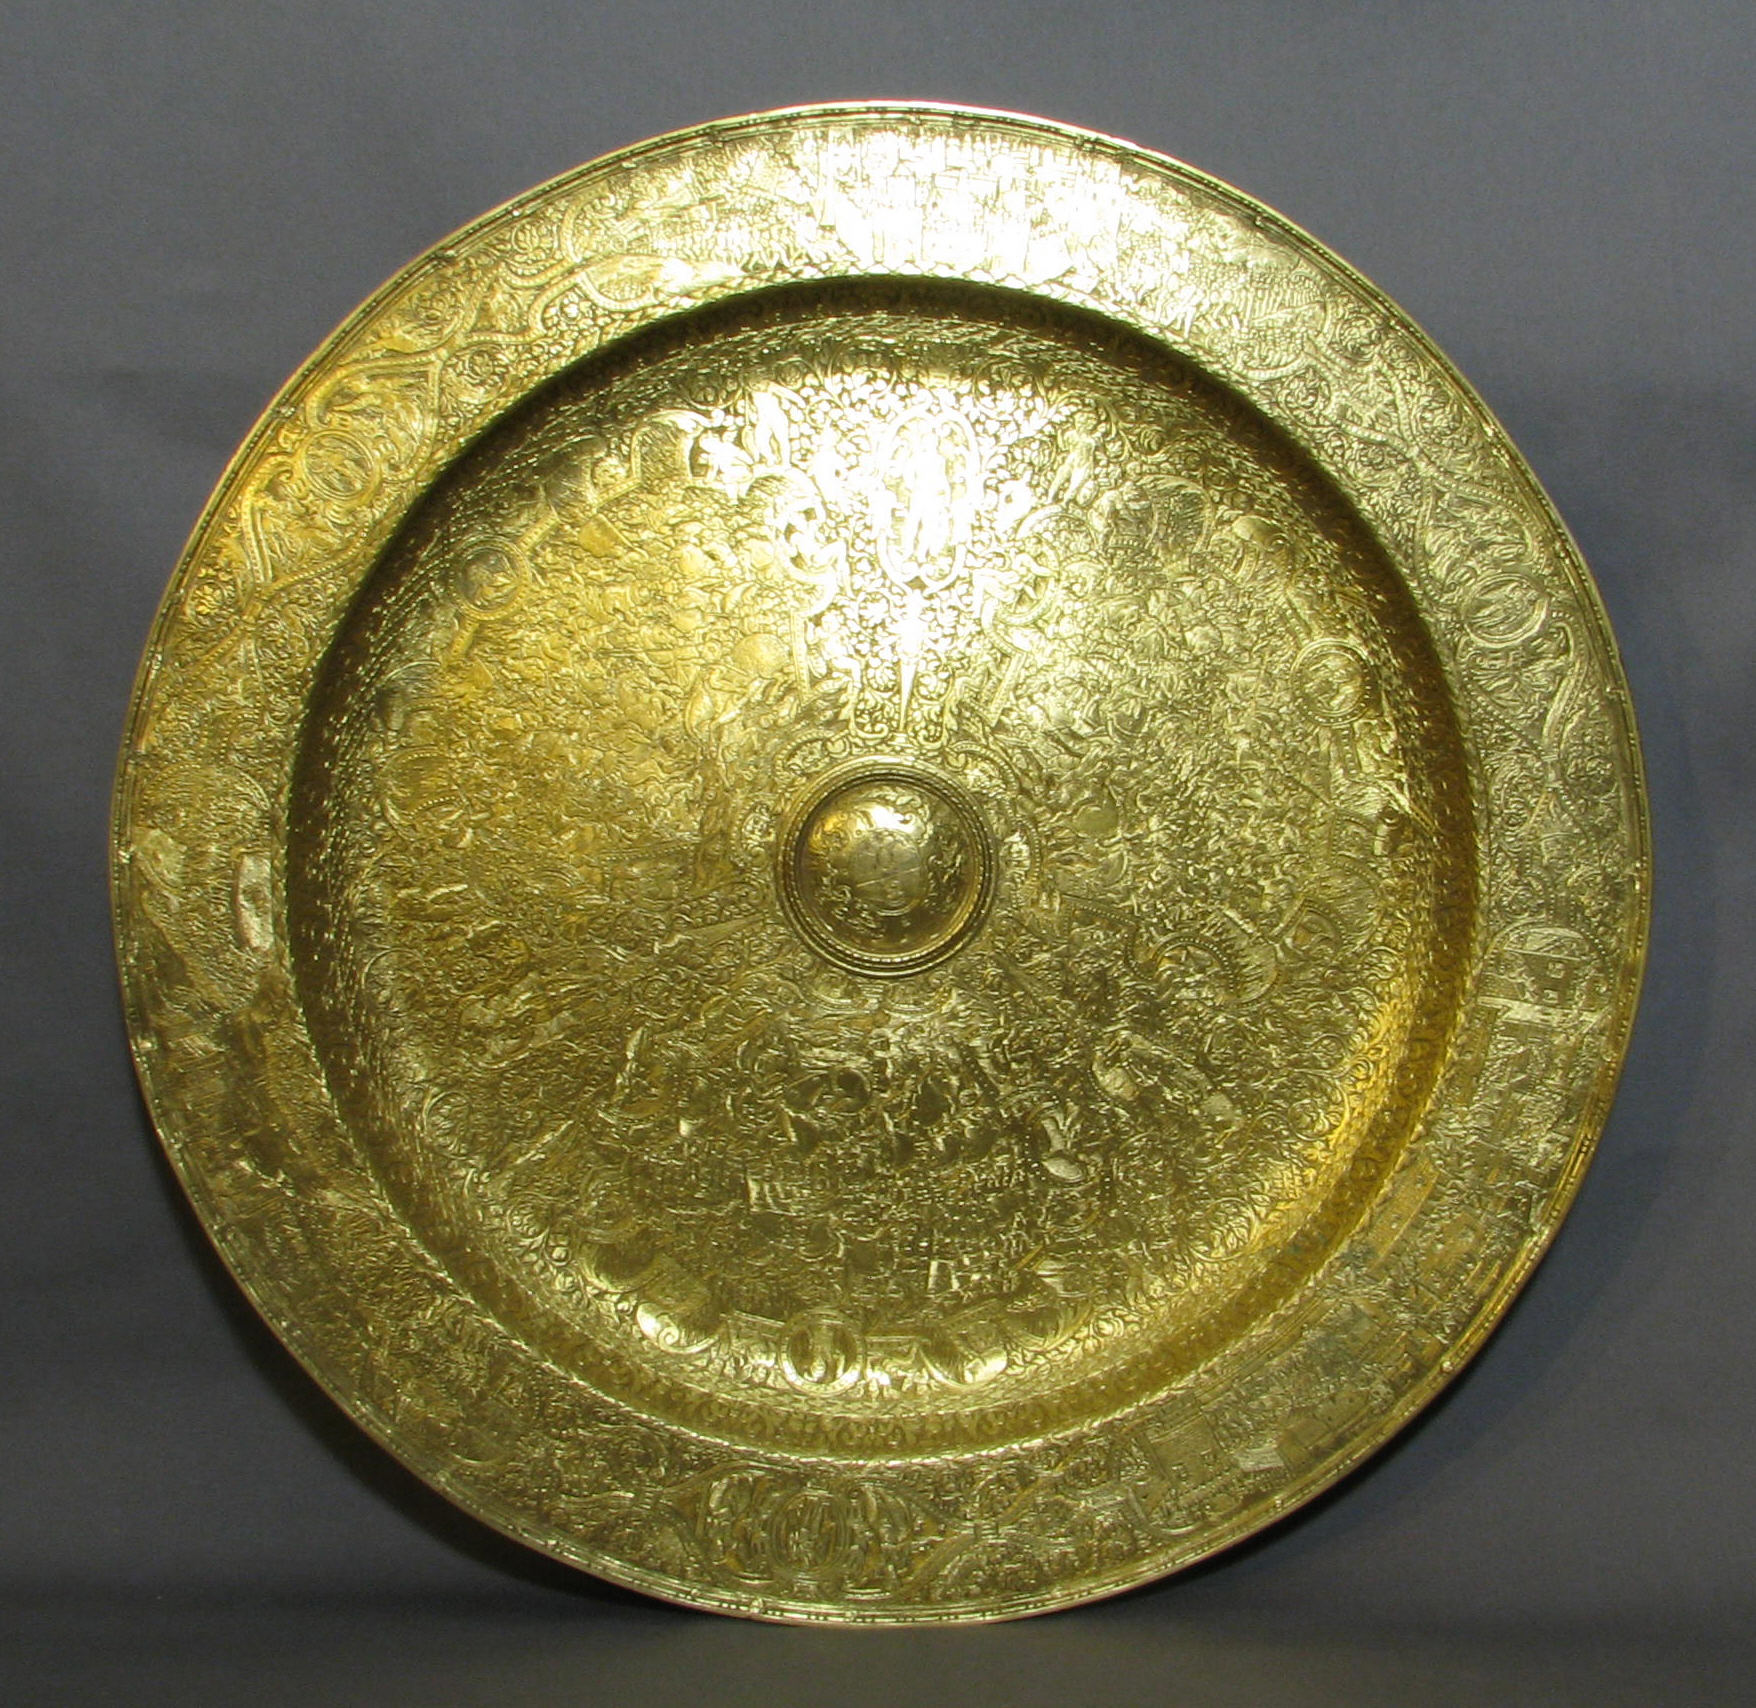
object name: salver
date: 1801-1900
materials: brass, gilt bronze